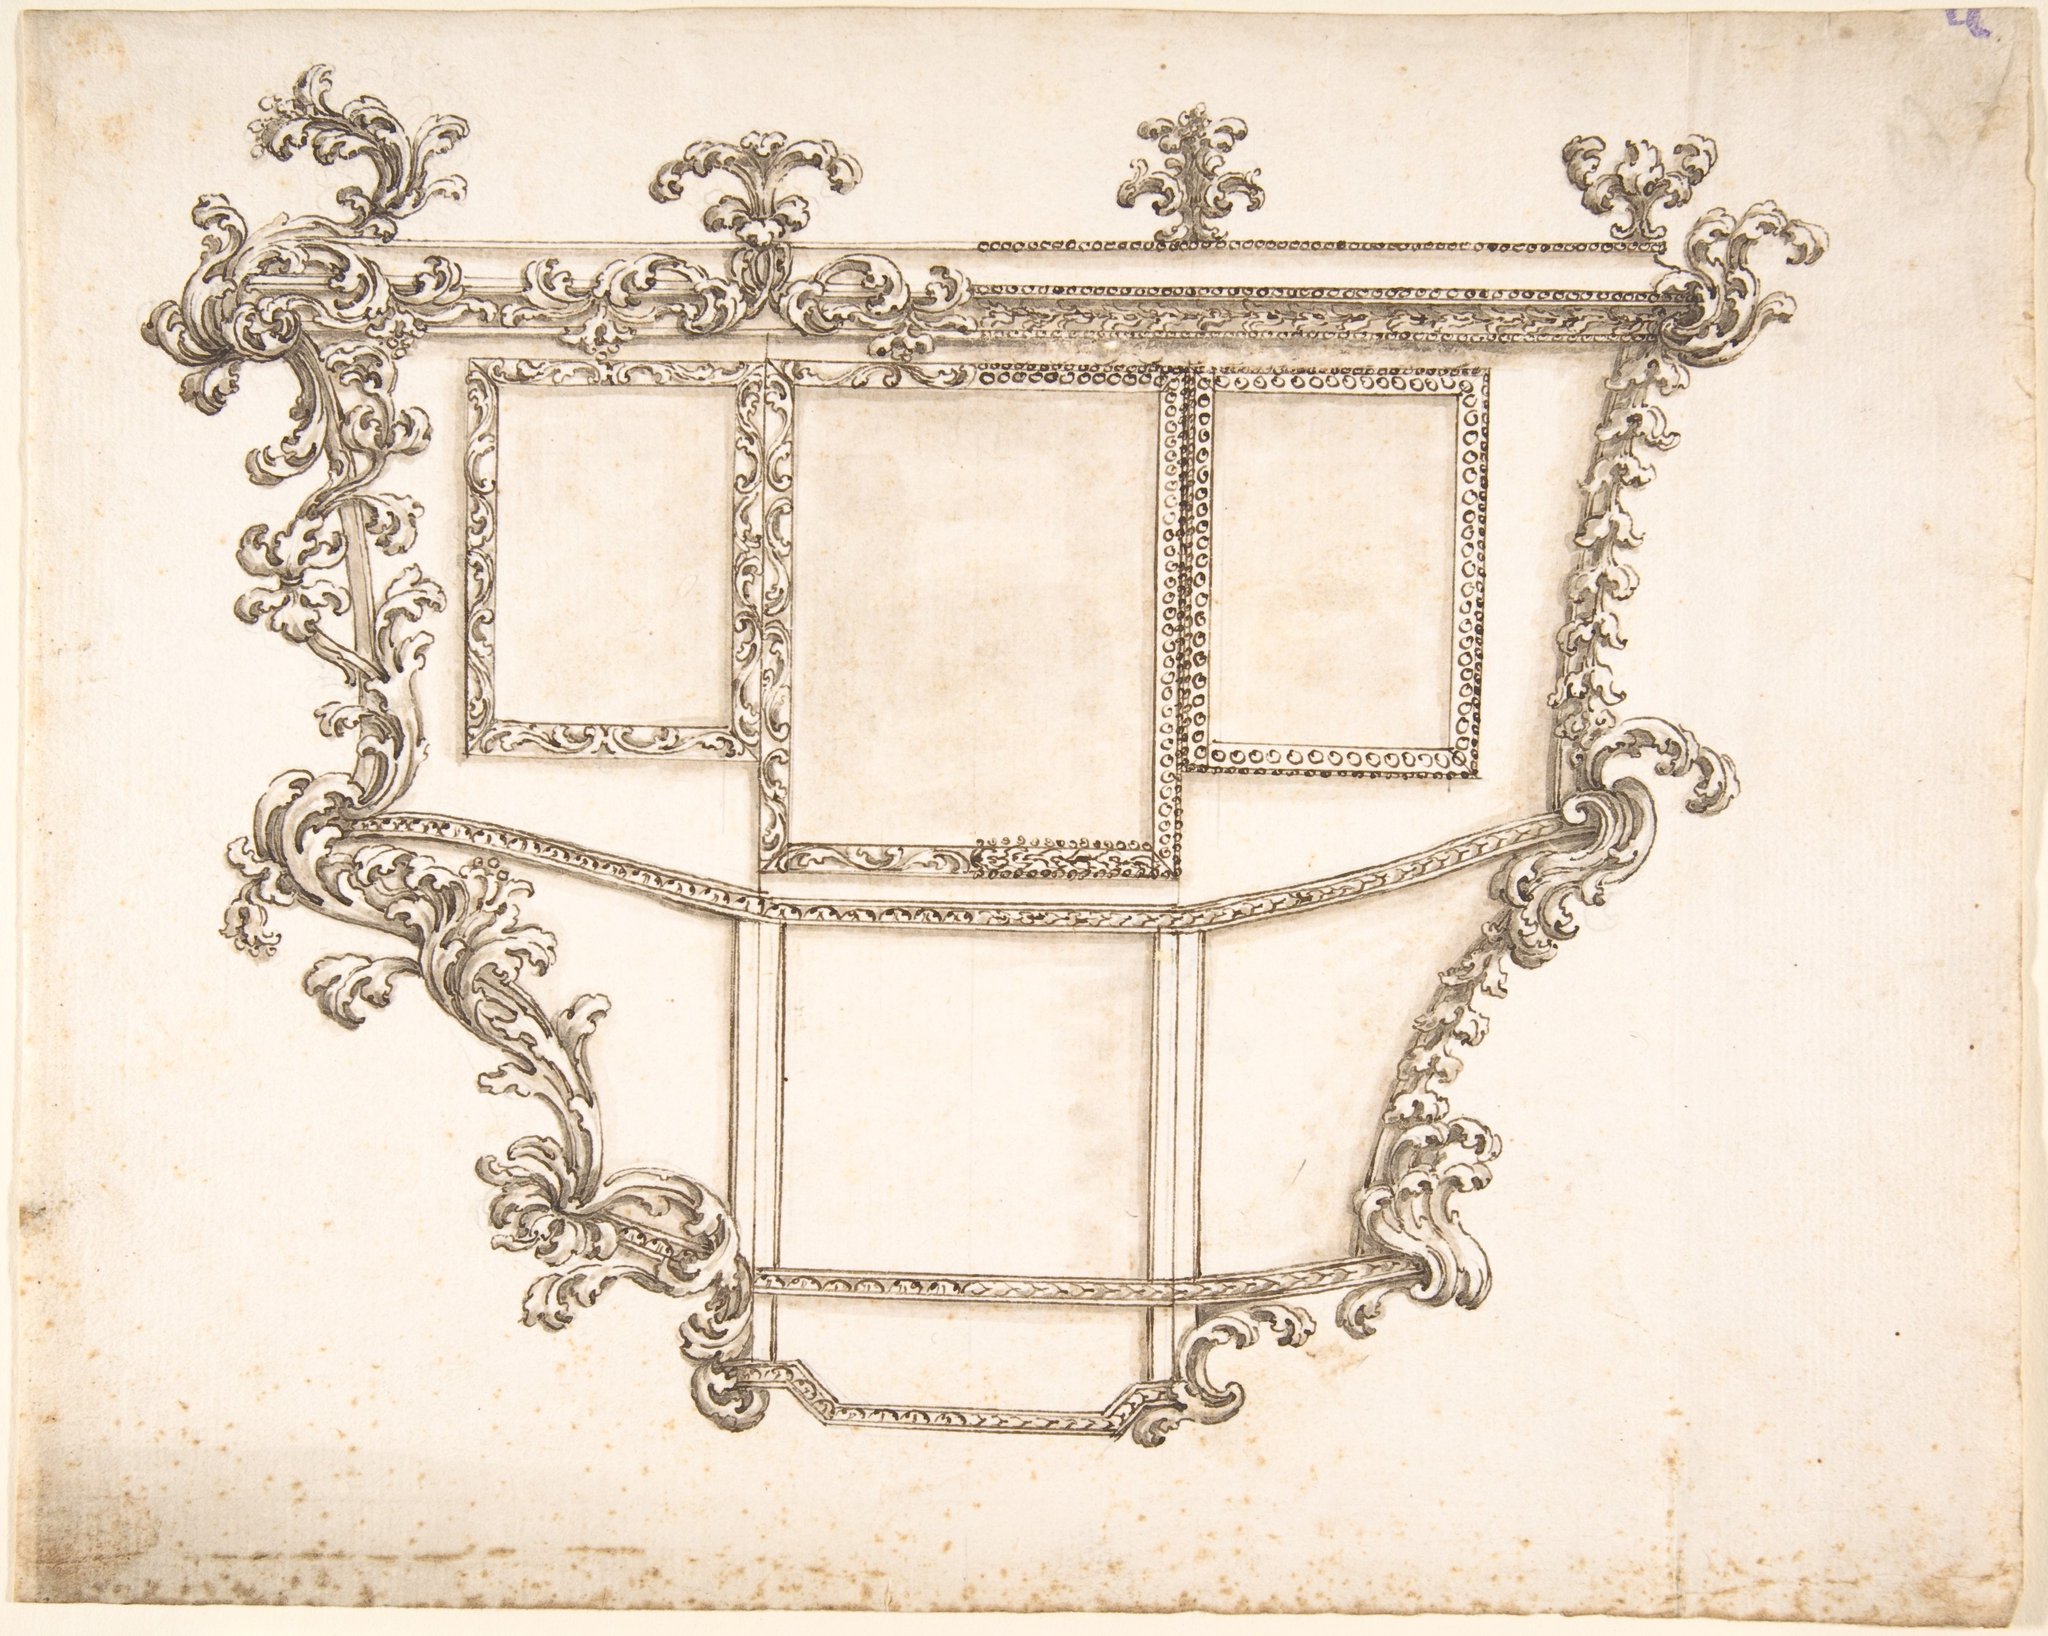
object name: drawing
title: Design for a Carriage with a Variant for the Decoration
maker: anonymous, italian, 17th or 18th century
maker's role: artist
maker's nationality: italian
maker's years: 1600-1799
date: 1601-1800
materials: ink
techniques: pen, wash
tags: carriages